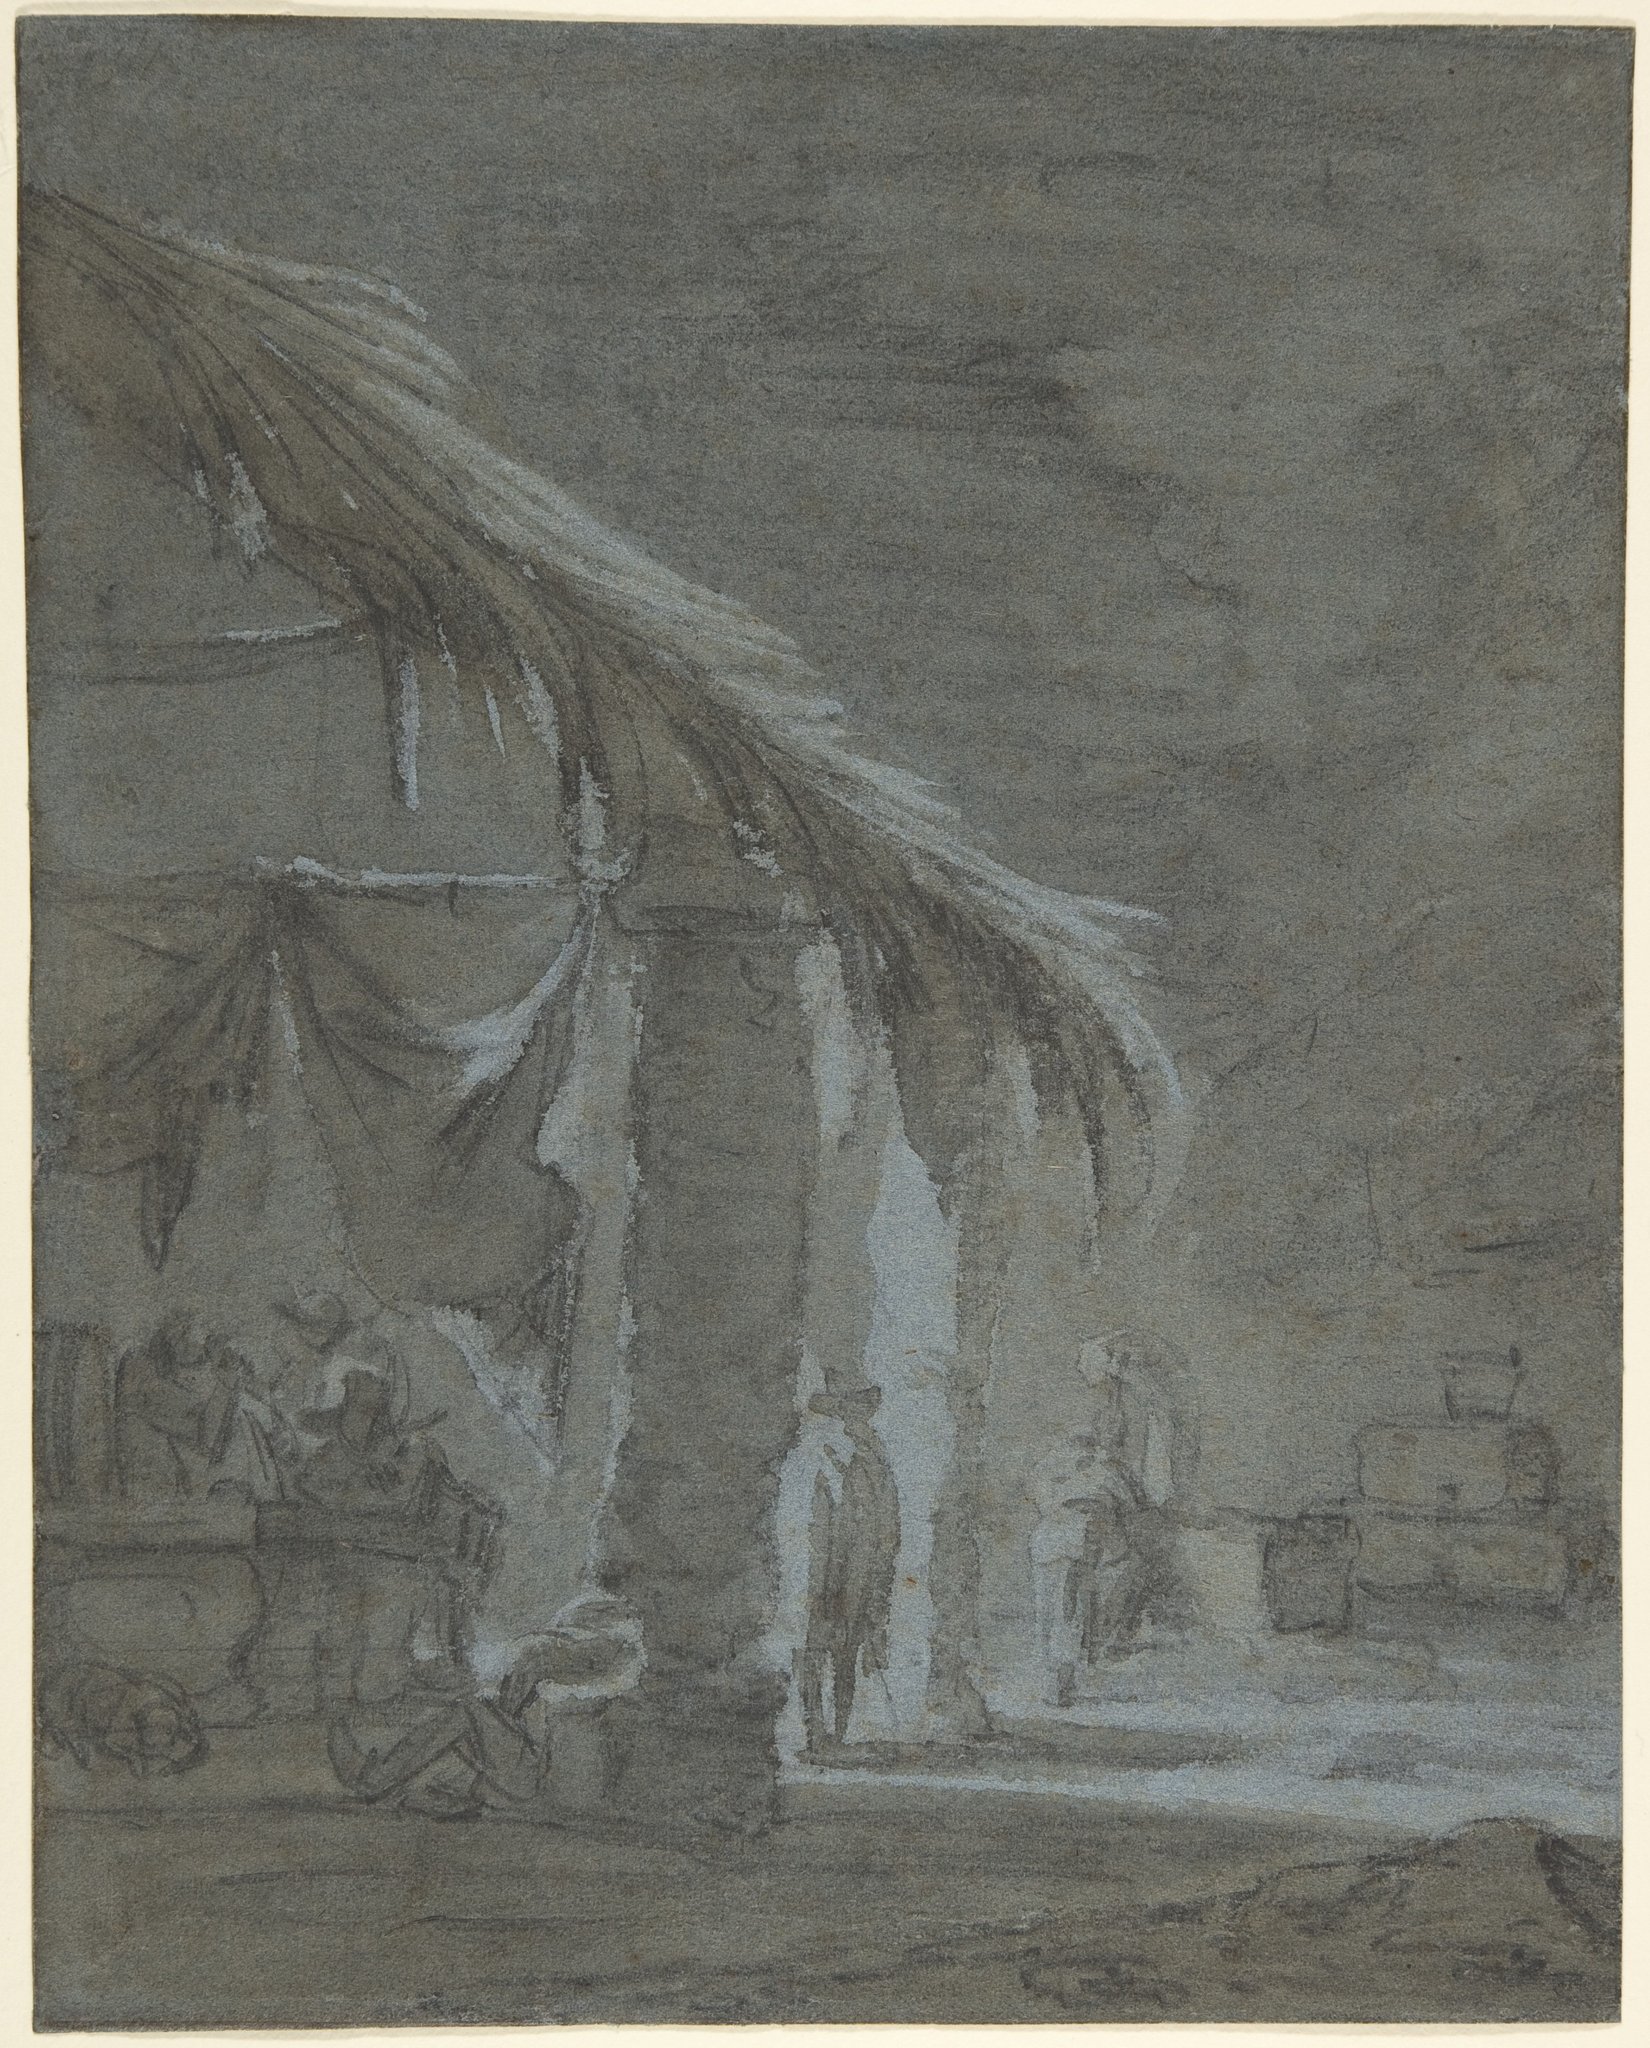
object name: drawing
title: Figures in an Outdoor Tavern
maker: jan asselijn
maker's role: artist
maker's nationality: dutch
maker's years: 1610-1652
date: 1635-1652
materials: chalk, ink, paper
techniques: brush, heightening, wash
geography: netherlands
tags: human figures,taverns